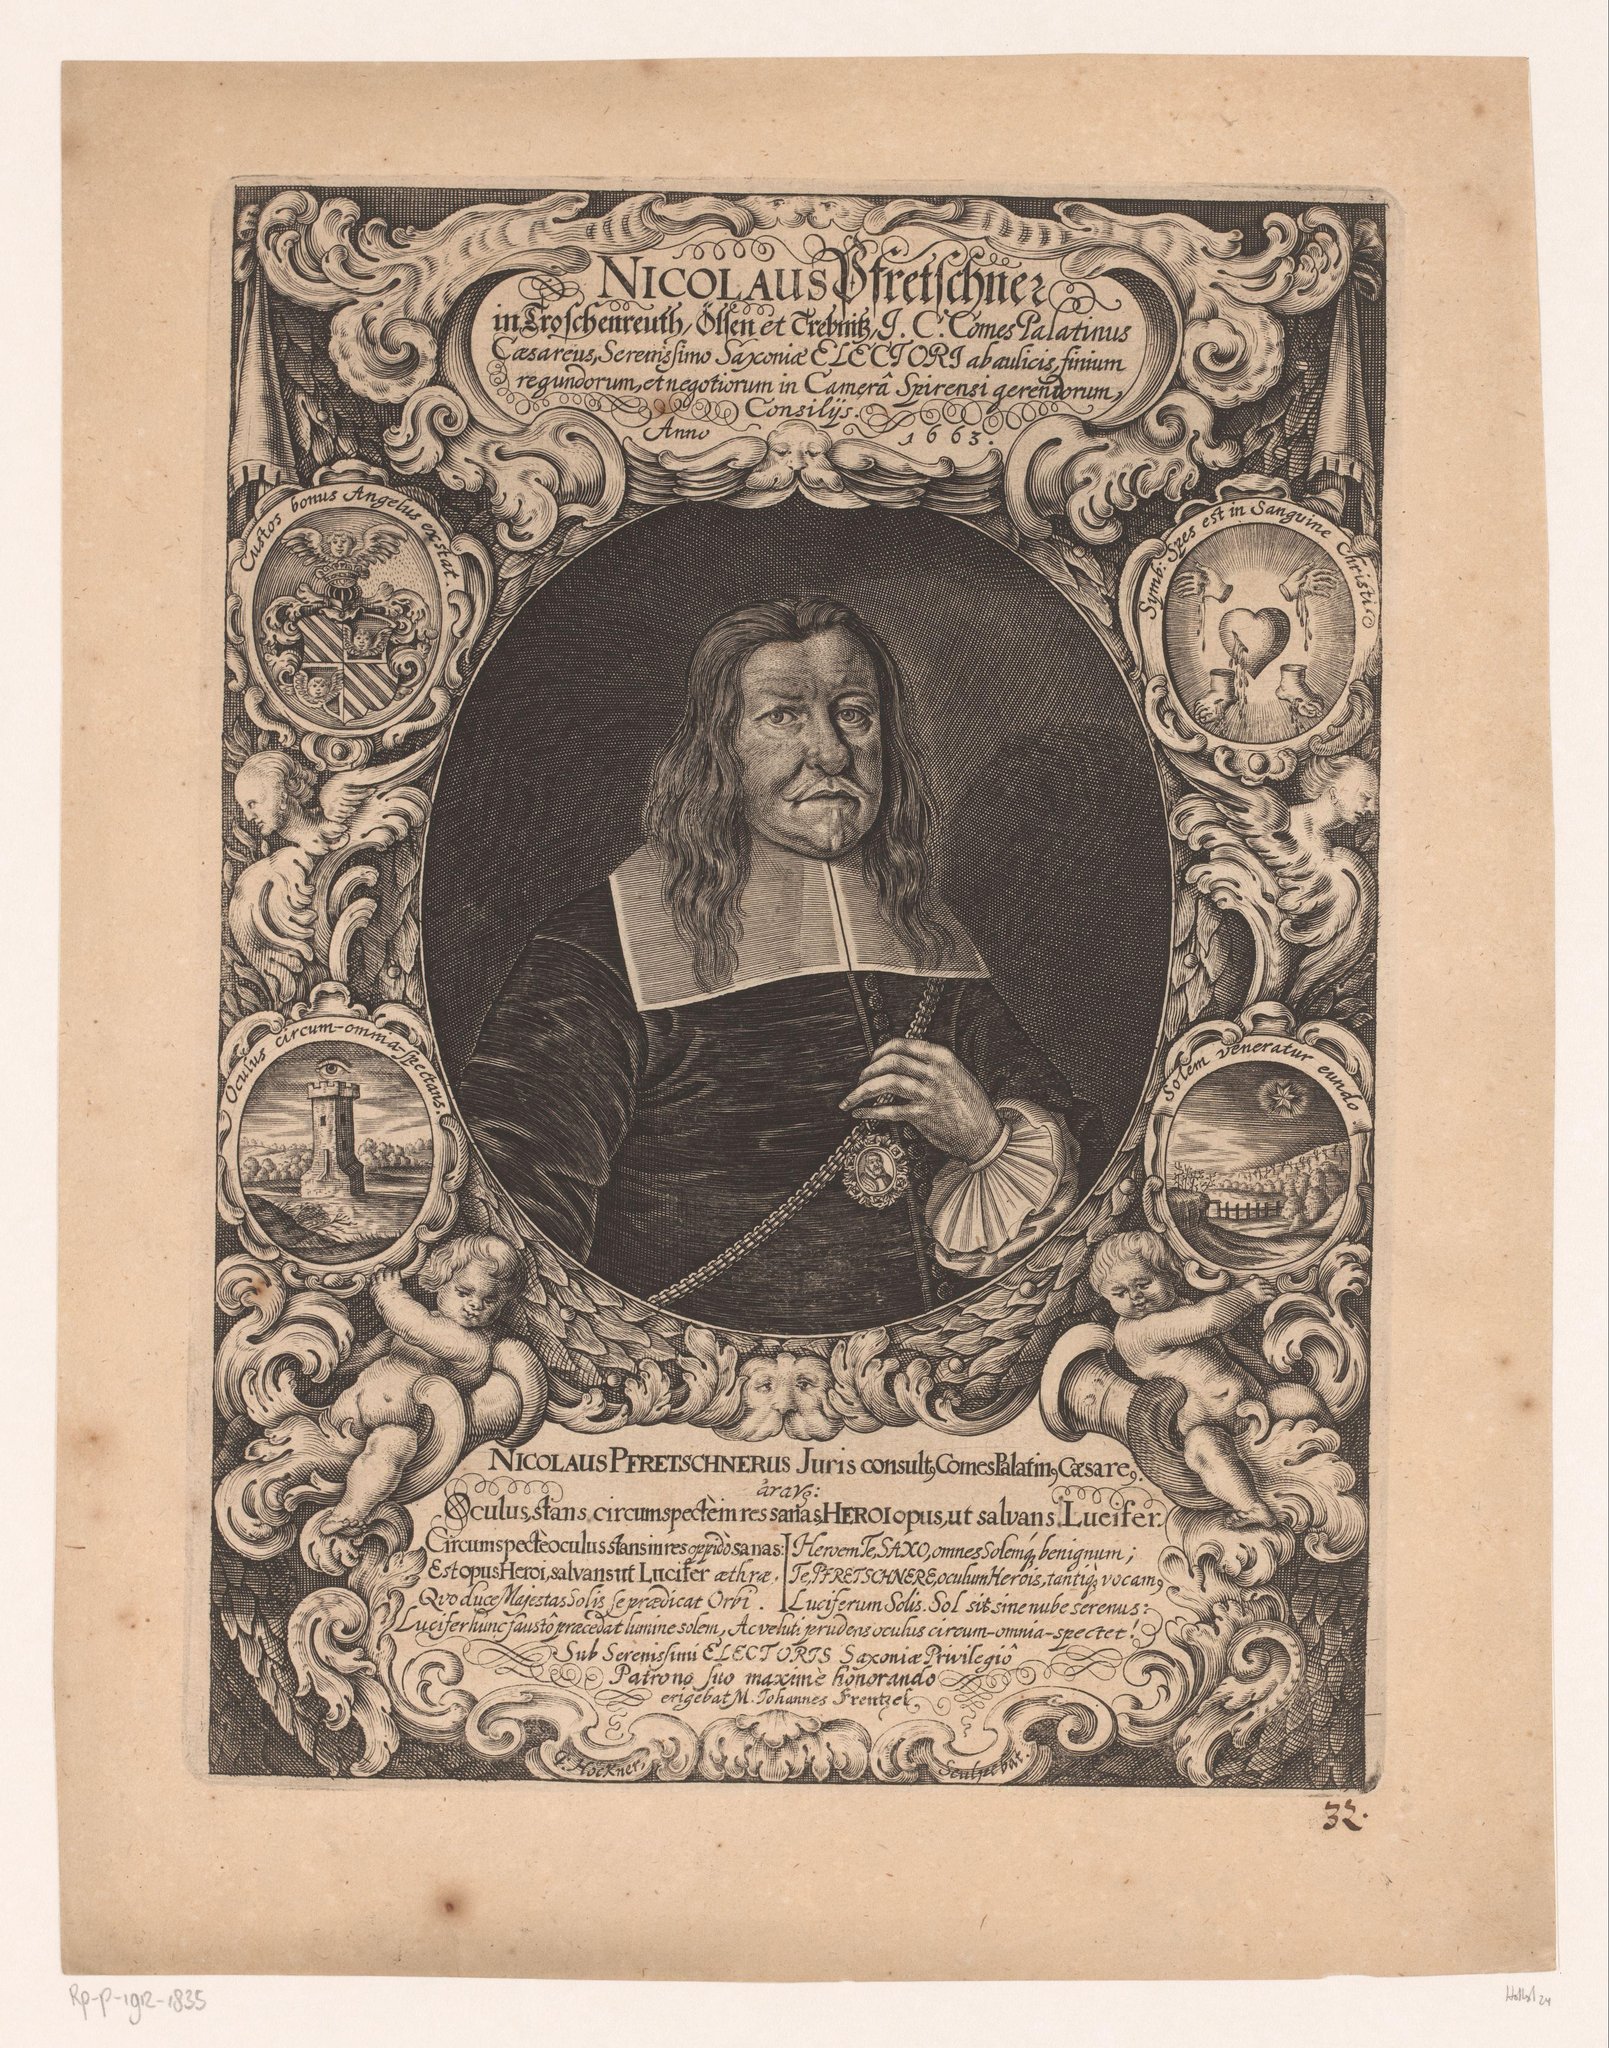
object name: print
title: Portret van Nicolaus Pfretzschner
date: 1663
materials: paper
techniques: engraving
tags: the five wounded limbs of christ: heart (side-wound), hands, and feet, historical persons, ornament ~ cartouche, abstract ideas and concepts (+ emblematical representation of concept), armorial bearing, heraldry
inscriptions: number: ‘32.’, collector's mark: Lugt 2228